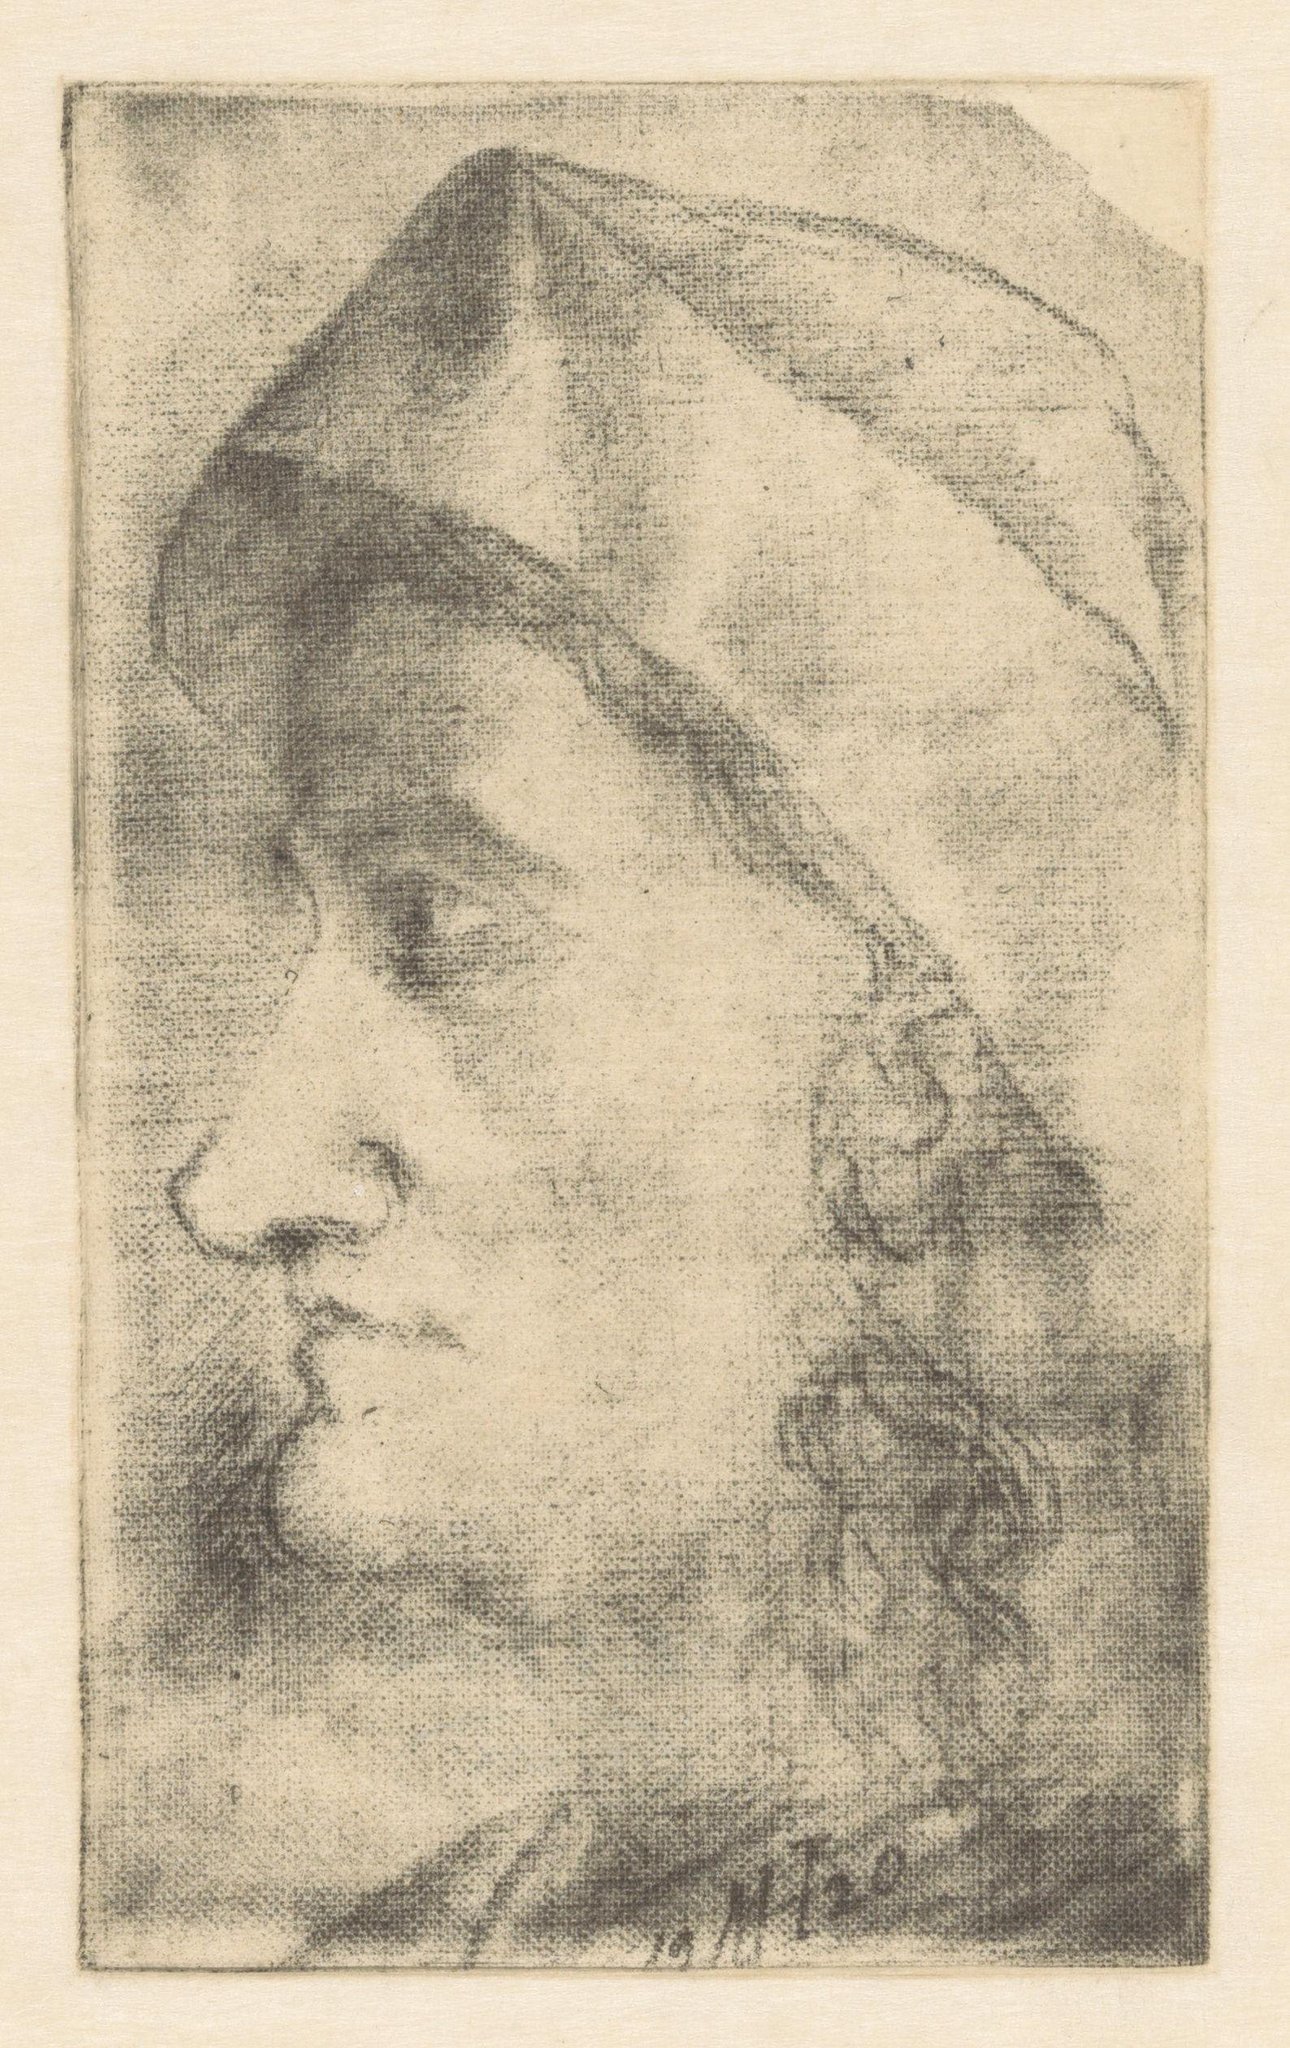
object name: print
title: Vrouw met muts en profil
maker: marius holleman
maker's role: draughtsman, print maker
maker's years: 1878-1926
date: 1920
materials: paper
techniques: etching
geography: groningen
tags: head-gear: hat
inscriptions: collector's mark: Lugt 2228